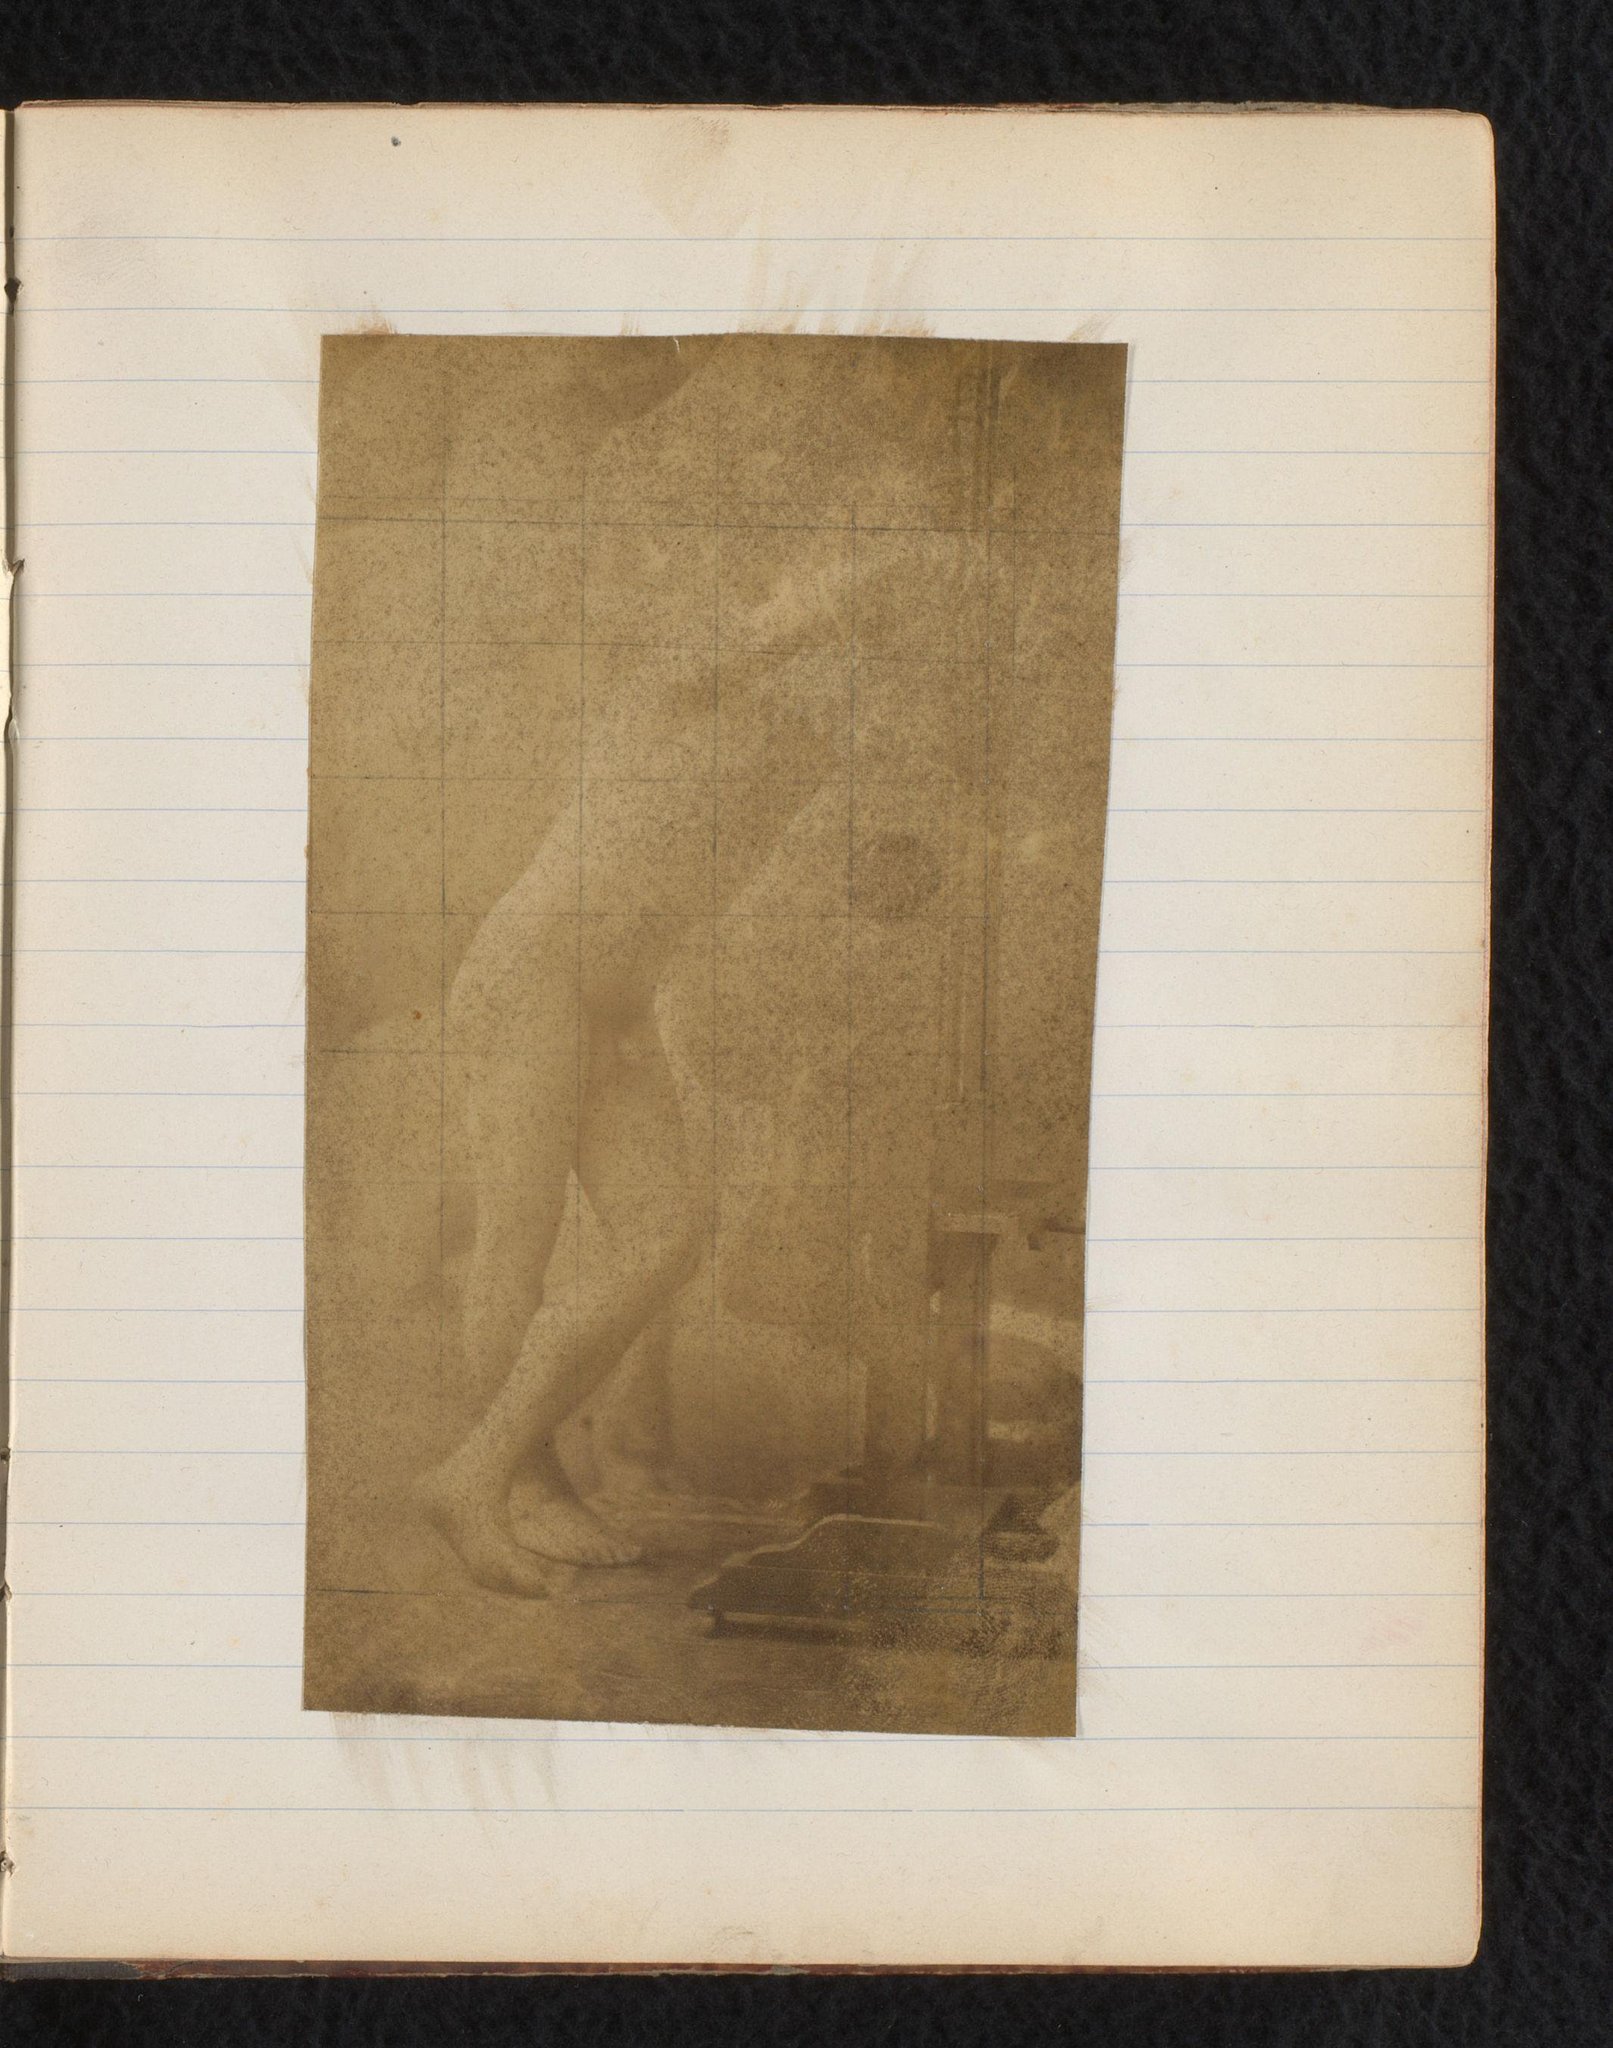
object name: photograph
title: Studie van een mannelijk naaktmodel, staand en leunend tegen een schildersezel, in het atelier van Jacques de Lalaing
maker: jacques lalaing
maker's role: painter, sculptor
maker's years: 1858-1917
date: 1883-1914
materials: pencil, photographic support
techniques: albumen print, drawing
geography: brussels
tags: adult man, artist (in general) working from nude model